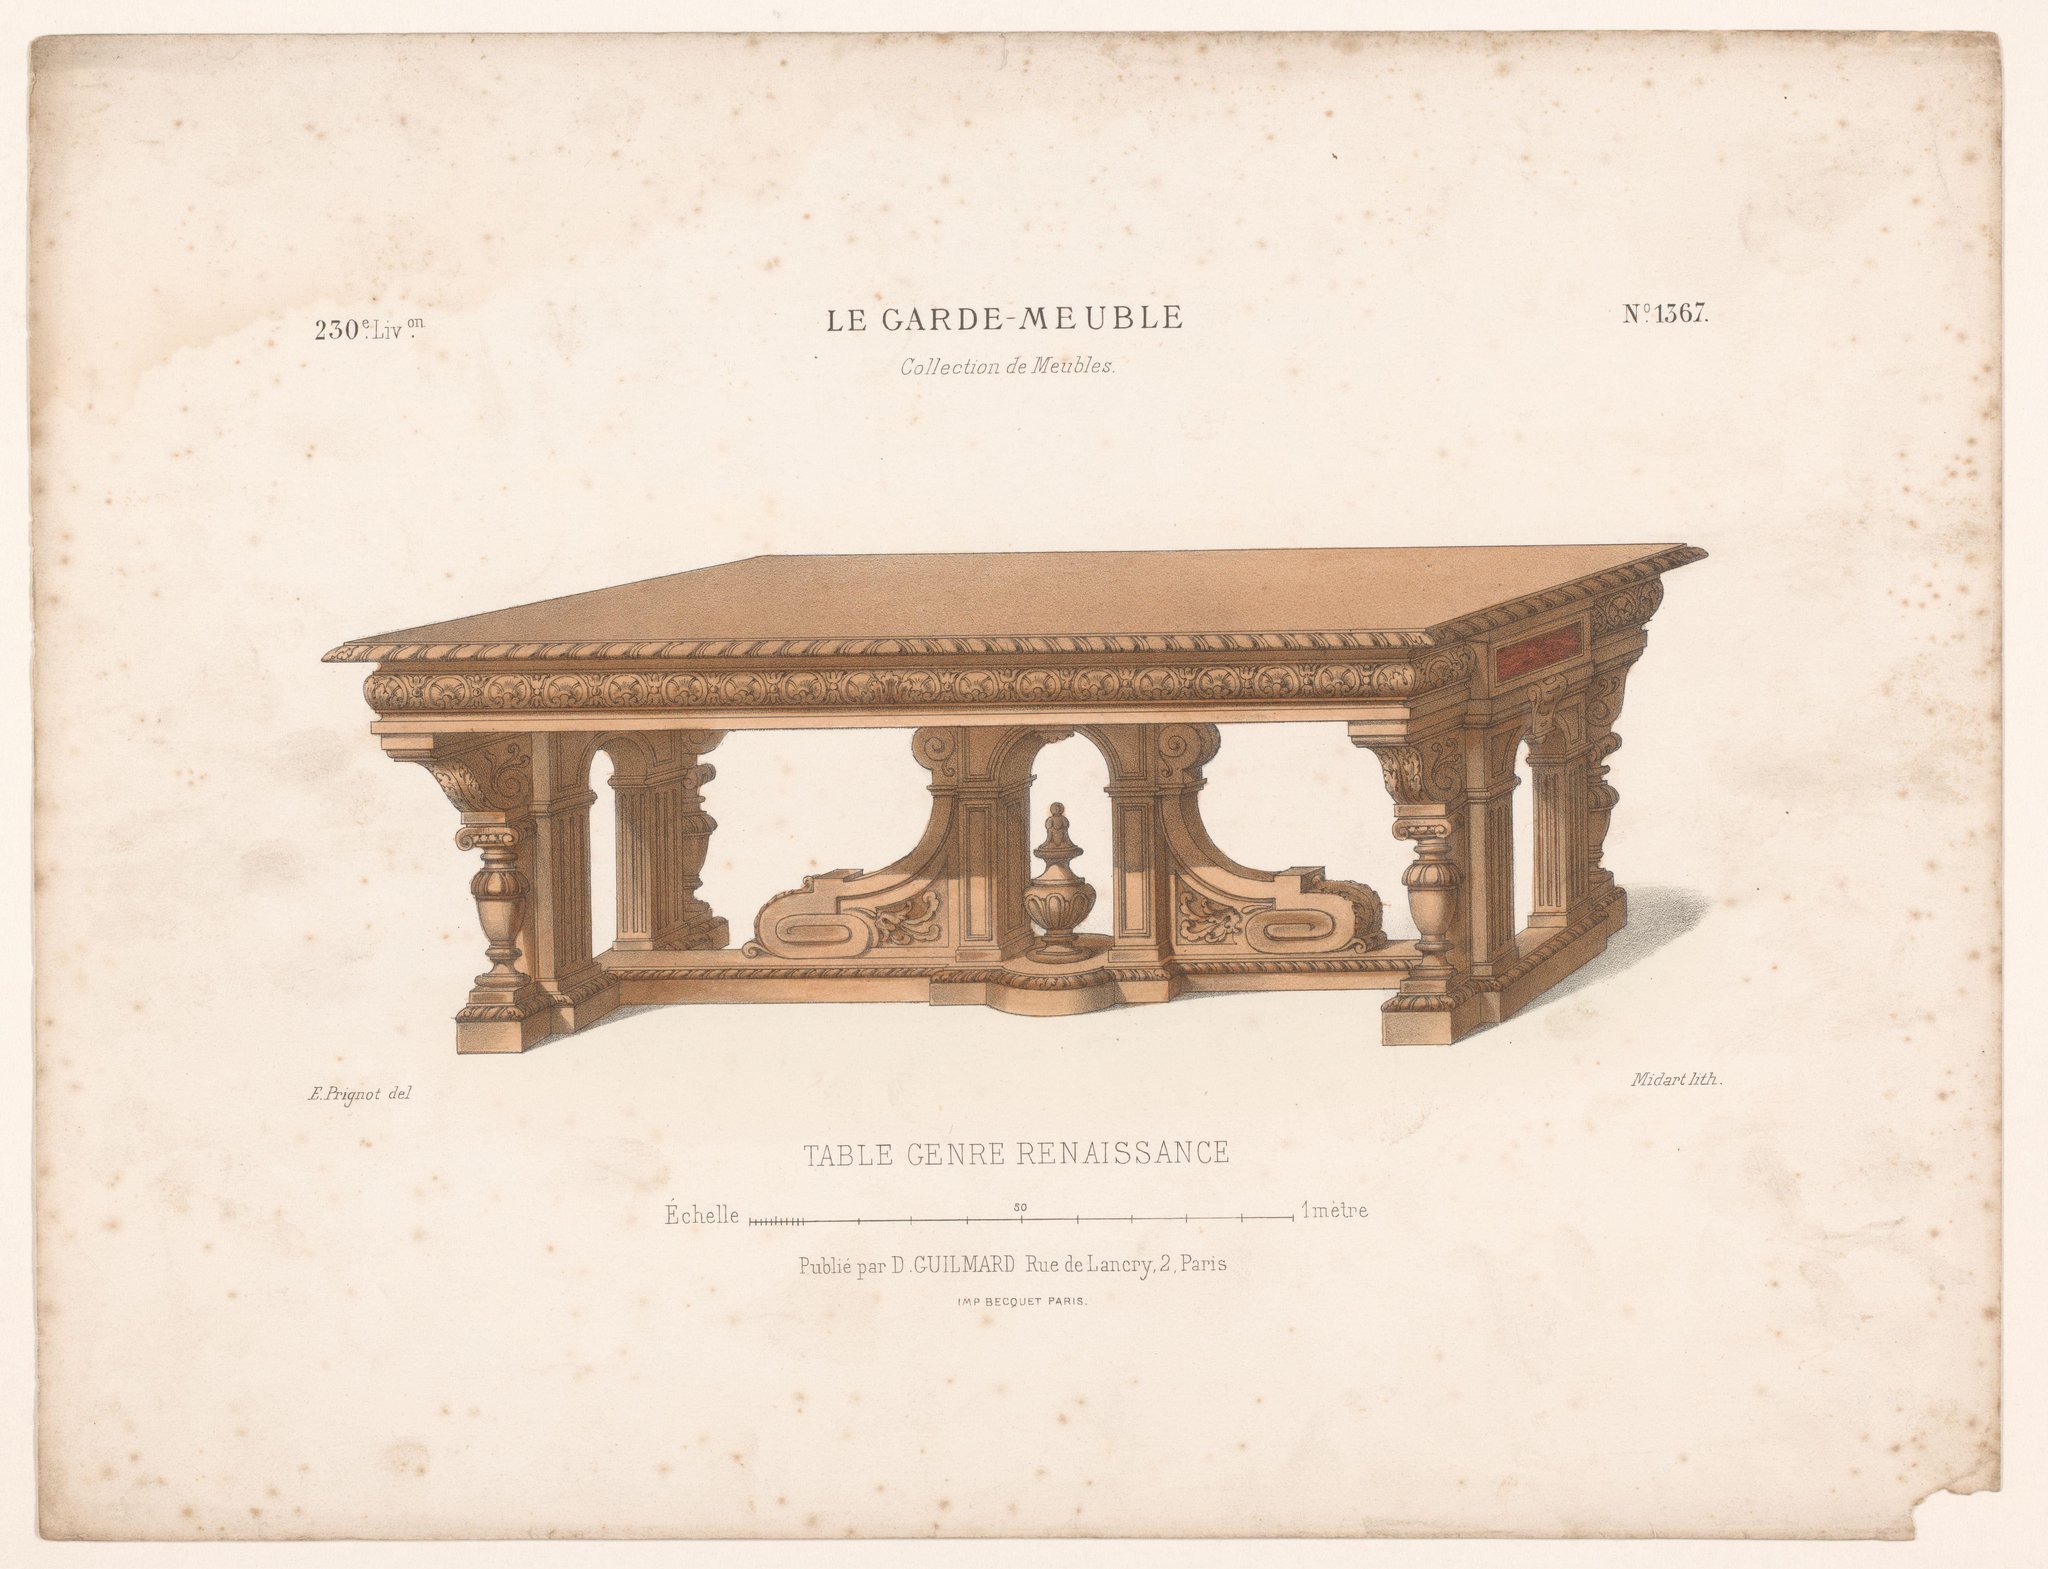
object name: print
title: Table genre renaissance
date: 1839-1885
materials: paper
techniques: hand coloring, lithograph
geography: paris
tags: table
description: Ieder Livraison in de serie Le Garde-Meuble bevat negen platen: drie 'sièges' (zitmeubels), drie 'meubles' (diverse meubels zoals tafels en kasten) en drie 'tentures' (gordijnen en draperieën).